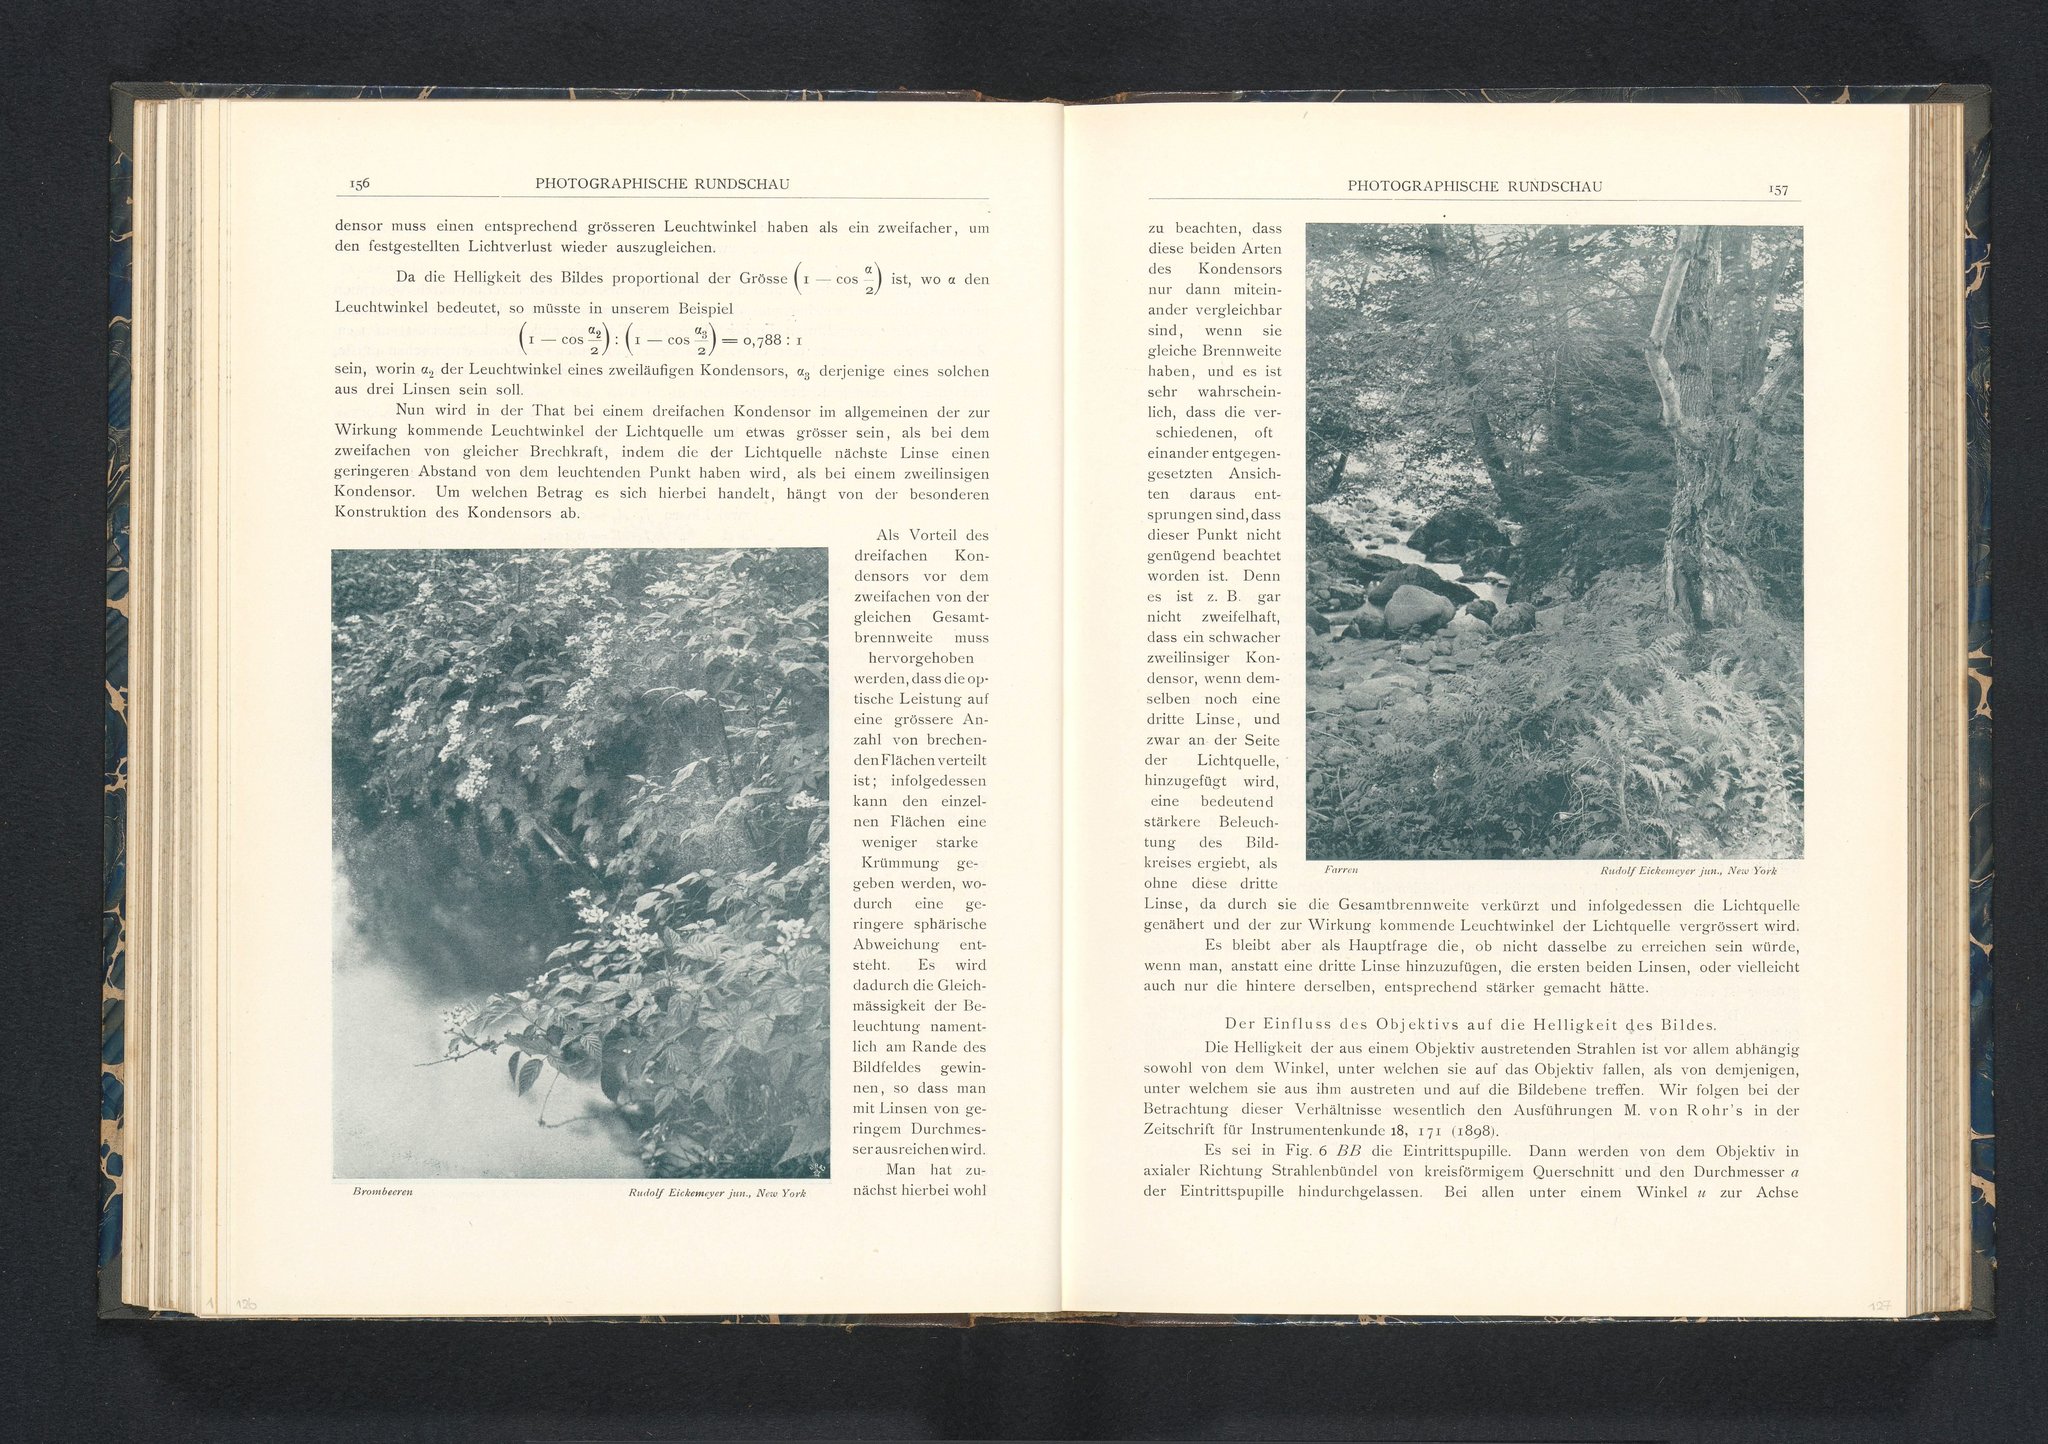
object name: page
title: Farren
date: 1896-1901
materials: paper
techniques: autotype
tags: ferns, forest, wood